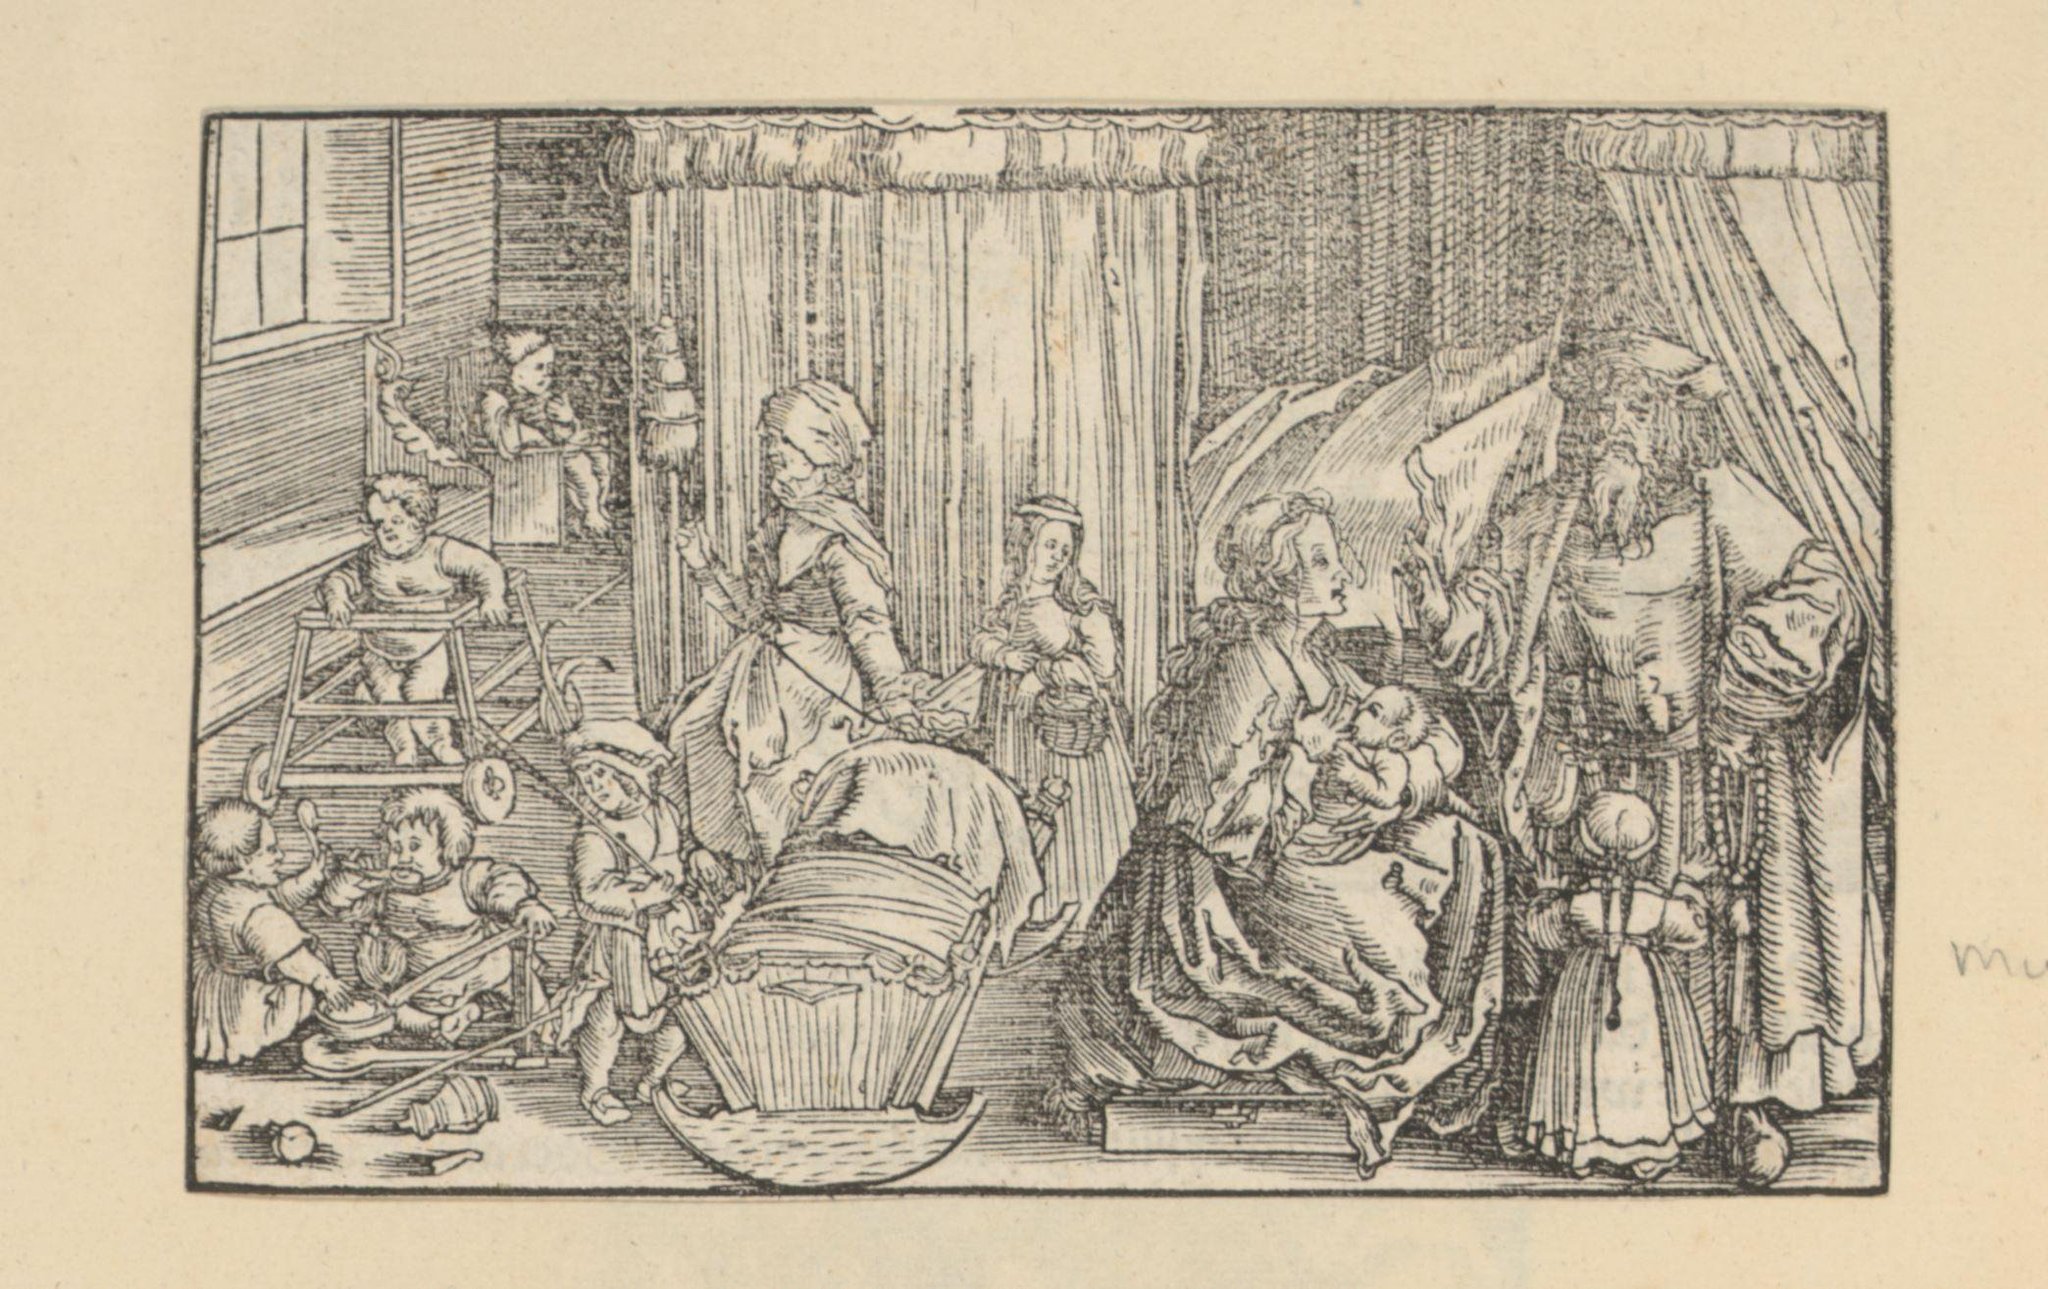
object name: book illustration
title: Grote familie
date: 1514-1532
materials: paper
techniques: letterpress printing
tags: family life at home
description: Deze prent is gebruikt in: Petrarca, Francesco. Von der Artzney bayder Glück, des guten und widerwertigen: unnd weß sich ain yeder inn Gelück und Unglück halten sol (...). Augsburg: Heinrich Steiner, 1532. Deze uitgave is ook bekend onder de titel 'Trostspiegel in Glück und Unglück'. Deze prent is ook gebruikt in: Cicero, Marcus Tulius. Officia M.T.C. Ein Buch so Marcus Tullius Cicero der Römer zu seynem (...). [Vertaald uit het Latijn door] Johann von Schwarzenberg. Augsburg: Heinrich Steiner, 1531.